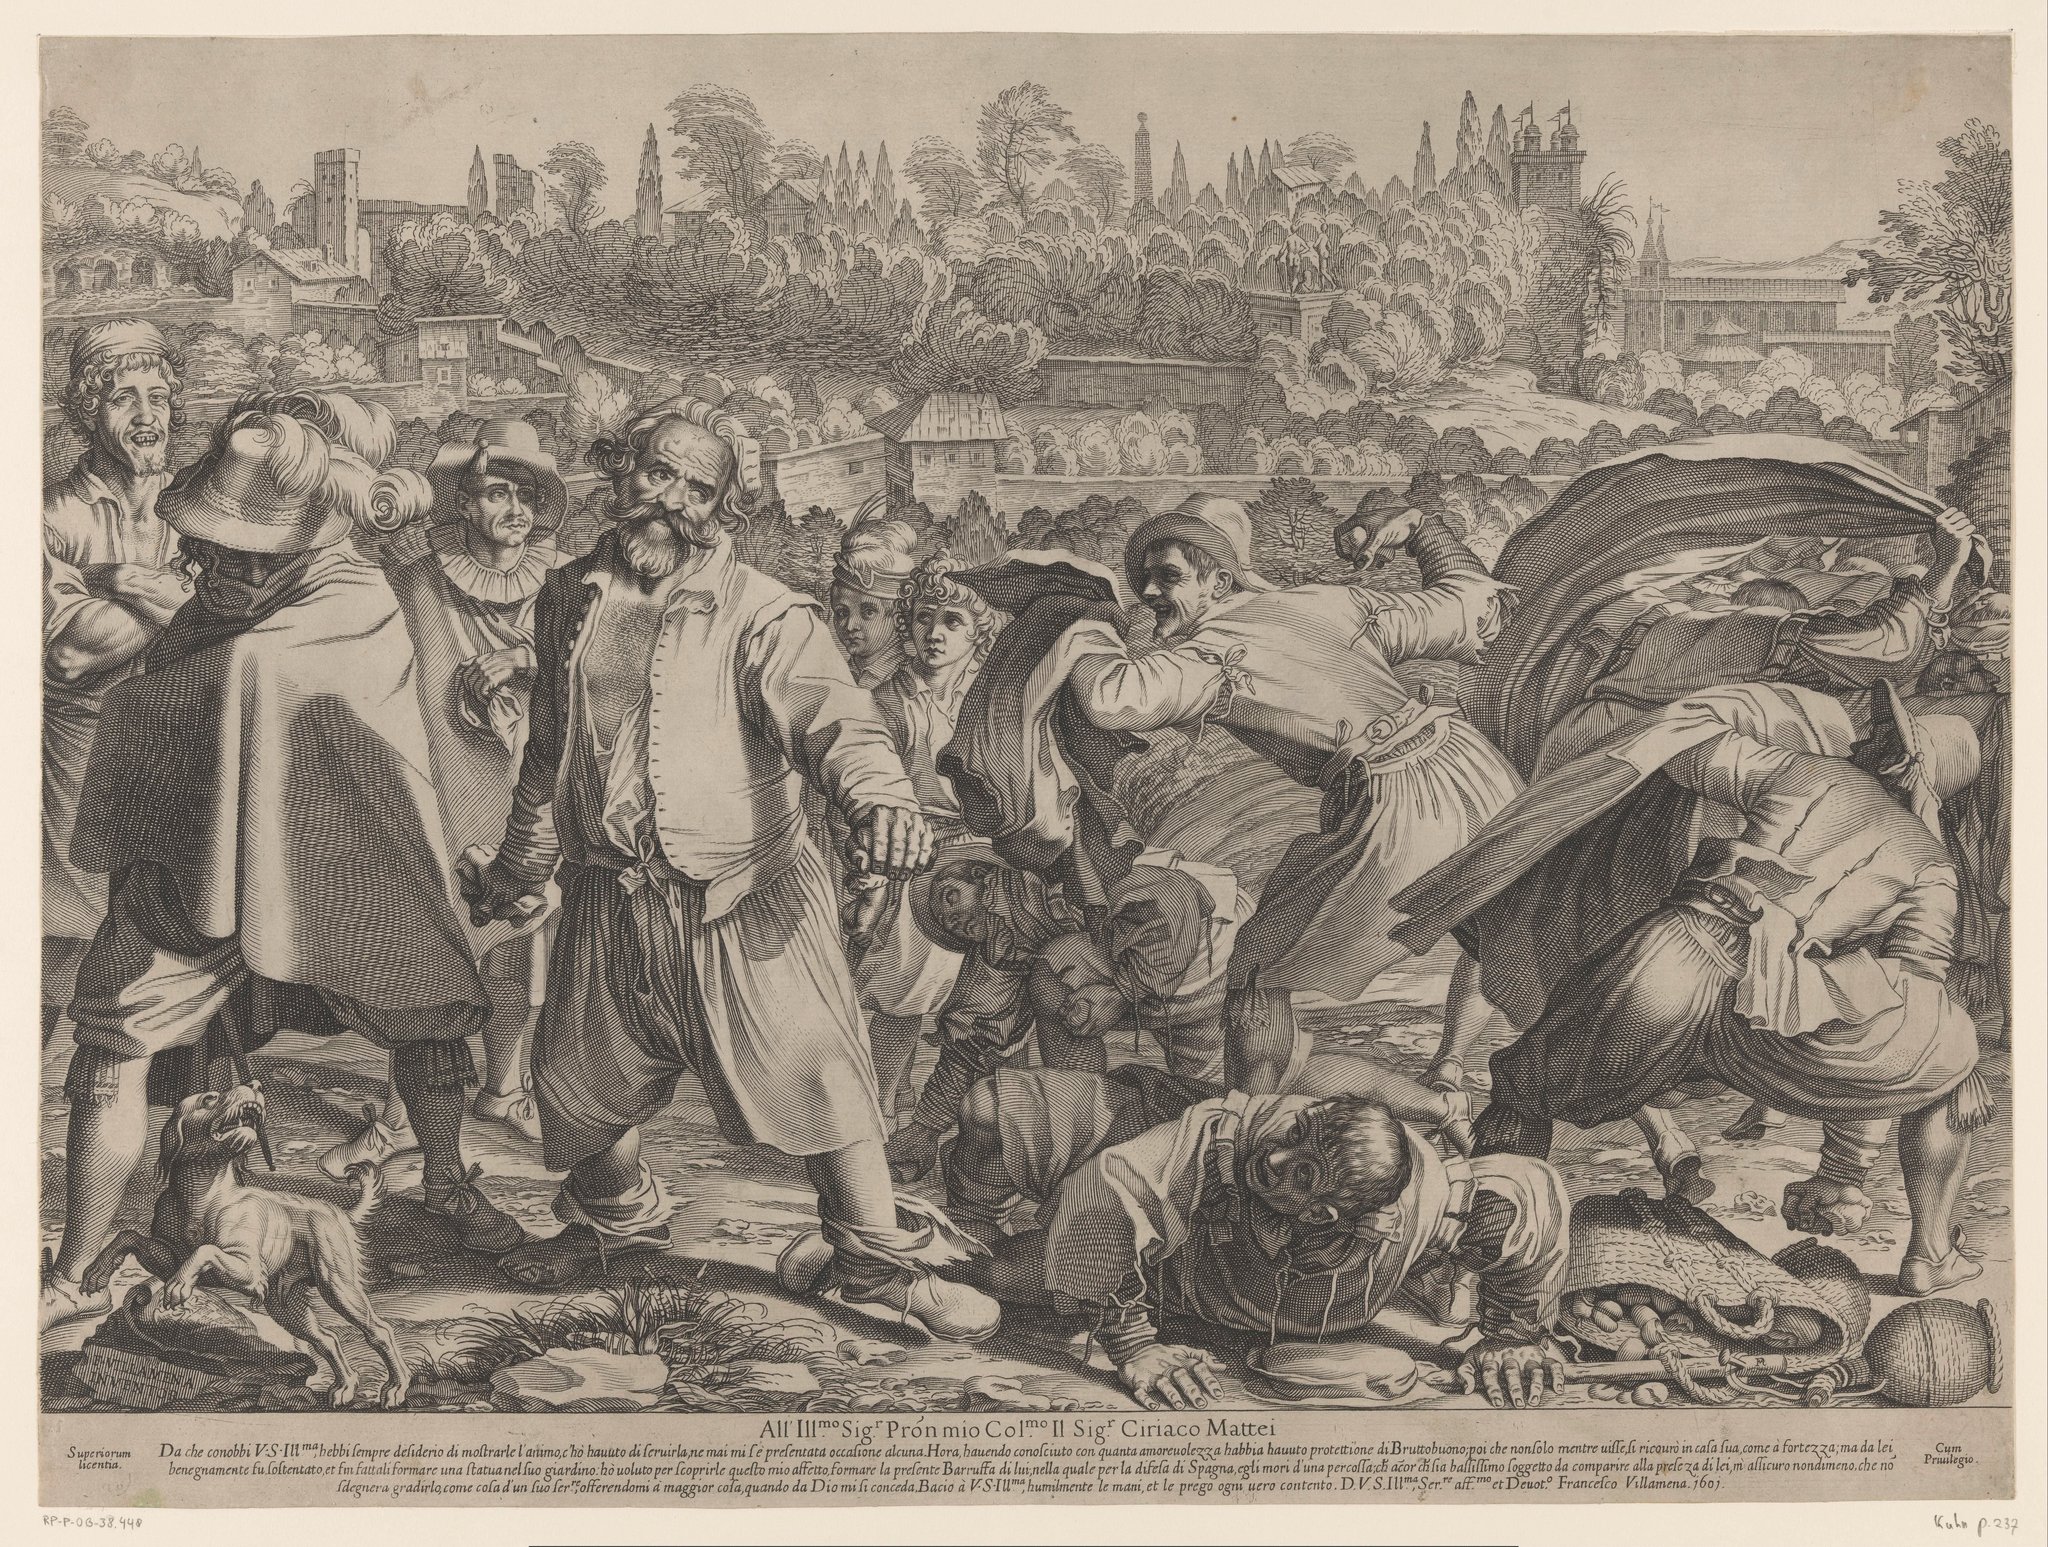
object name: print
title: Straatgevecht in Rome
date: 1601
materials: paper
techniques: engraving, intaglio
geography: italy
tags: street-fights, riots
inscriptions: collector's mark: Lugt 240, number: ‘12067’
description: Straatgevecht tussen aanhangers van Spaanse en Franse groeperingen in Rome. Links de aanhangers van de Spanjaarden onder leiding van Bruttobuono en rechts de aanhangers van de Fransen, gooiend met stenen. Op de achtergrond de berg Celio met de Villa Celimontana. Opdracht in ondermarge.